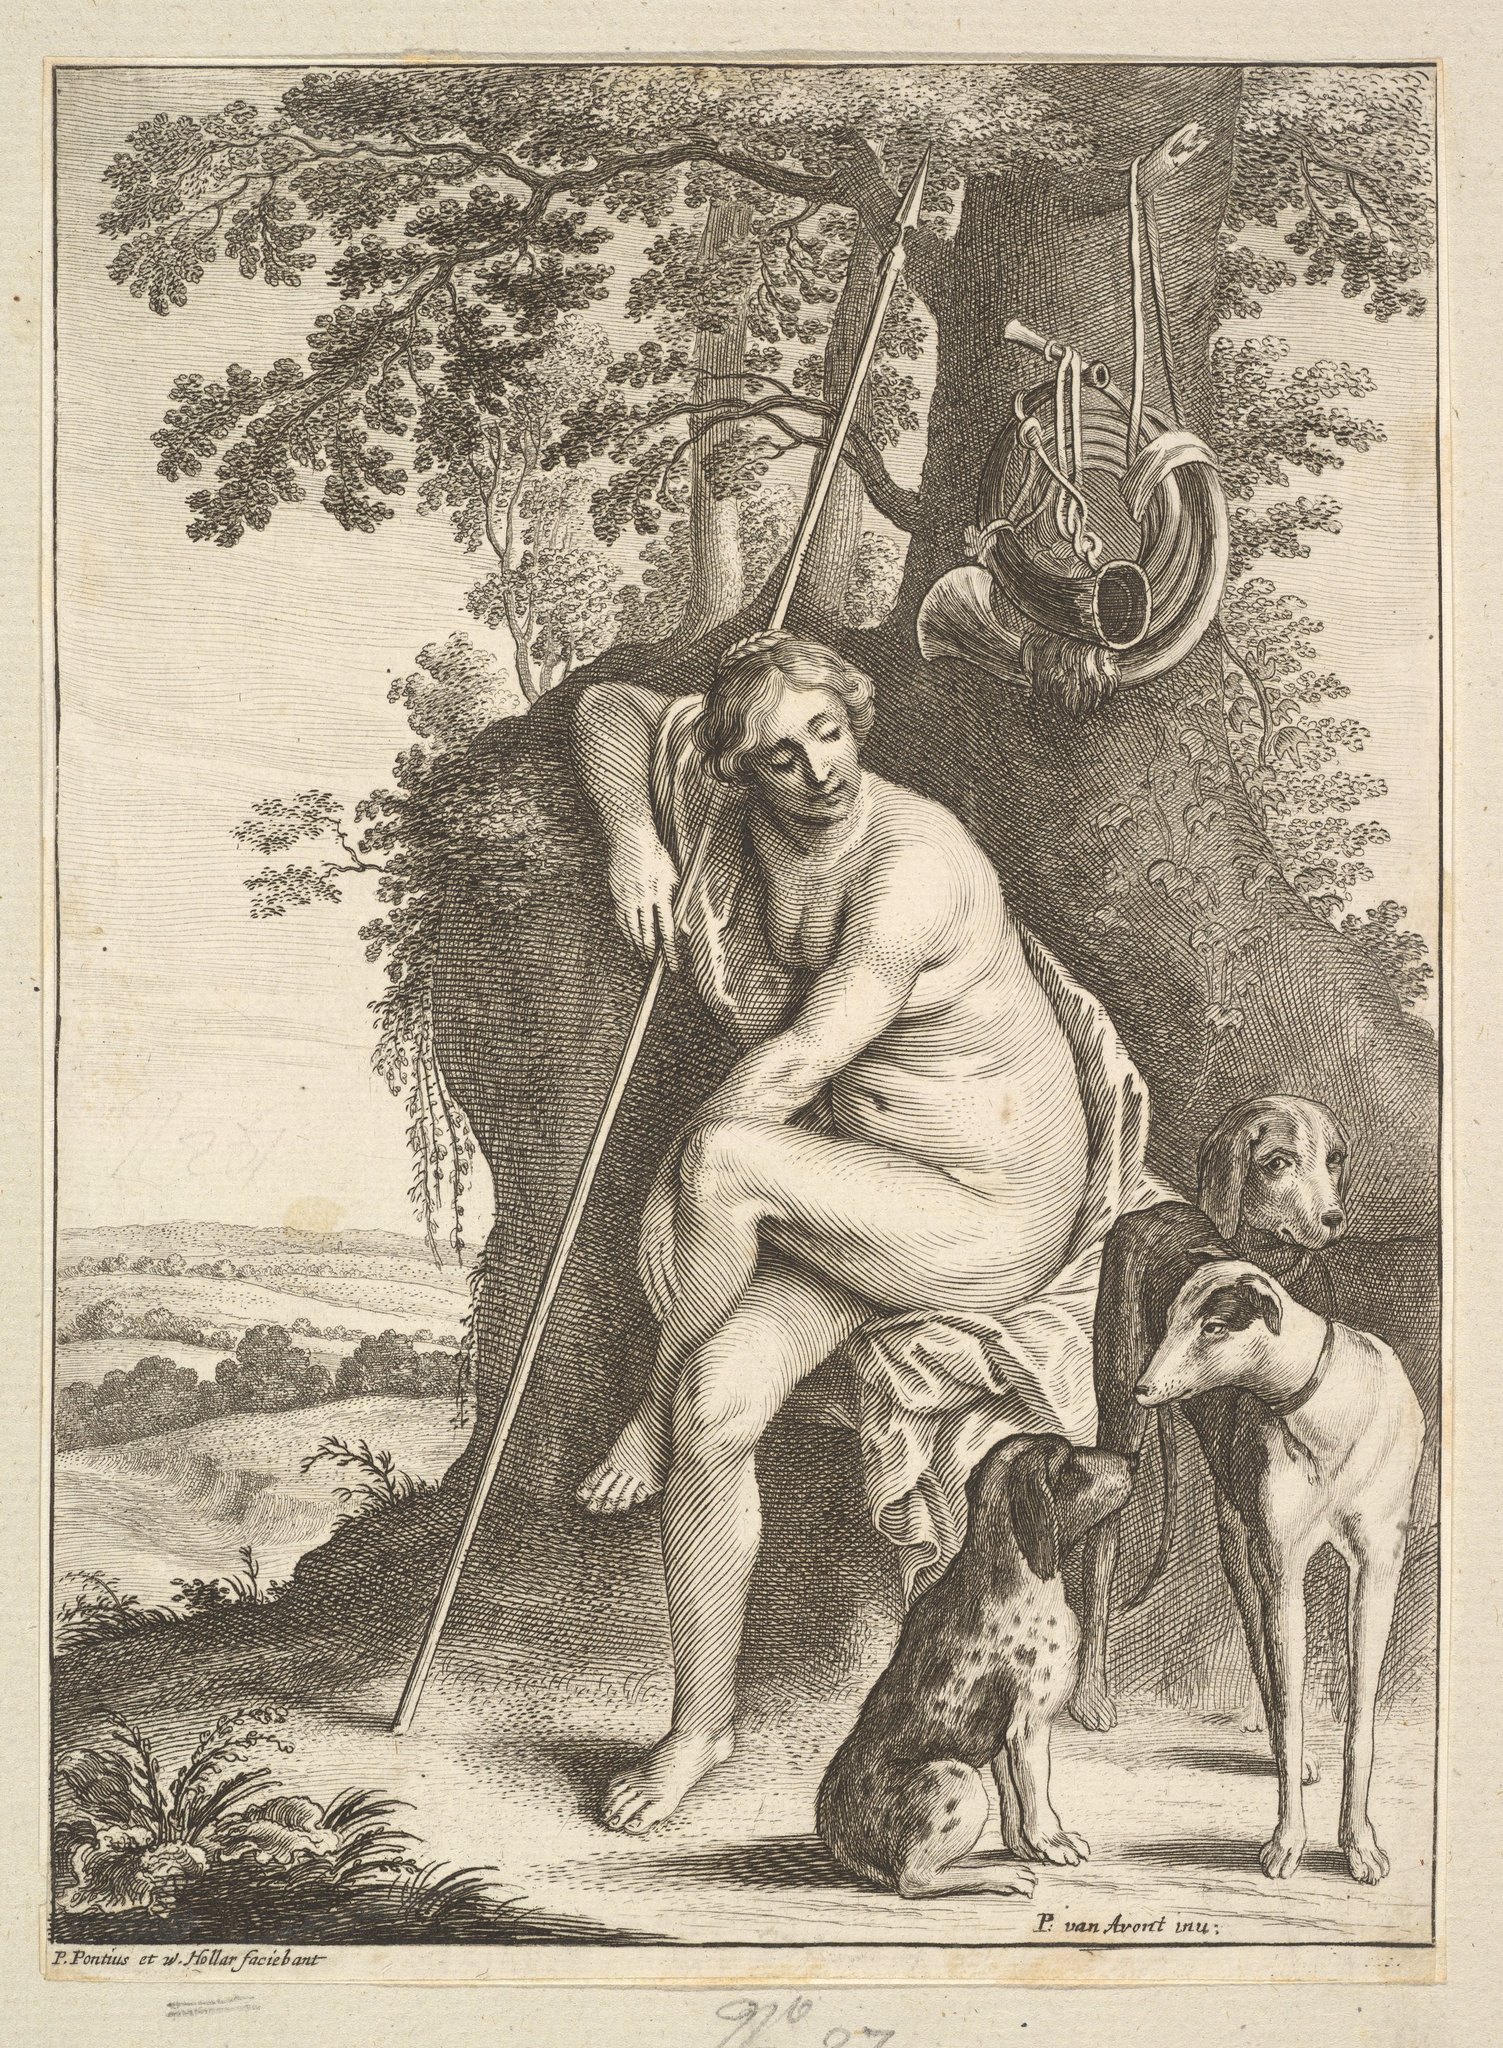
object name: print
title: Seated figure of Diana the huntress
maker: wenceslaus hollar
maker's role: artist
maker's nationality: bohemian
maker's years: 1607-1677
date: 1644-1652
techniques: drypoint, engraving, etching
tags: musical instruments,diana,dogs,trees